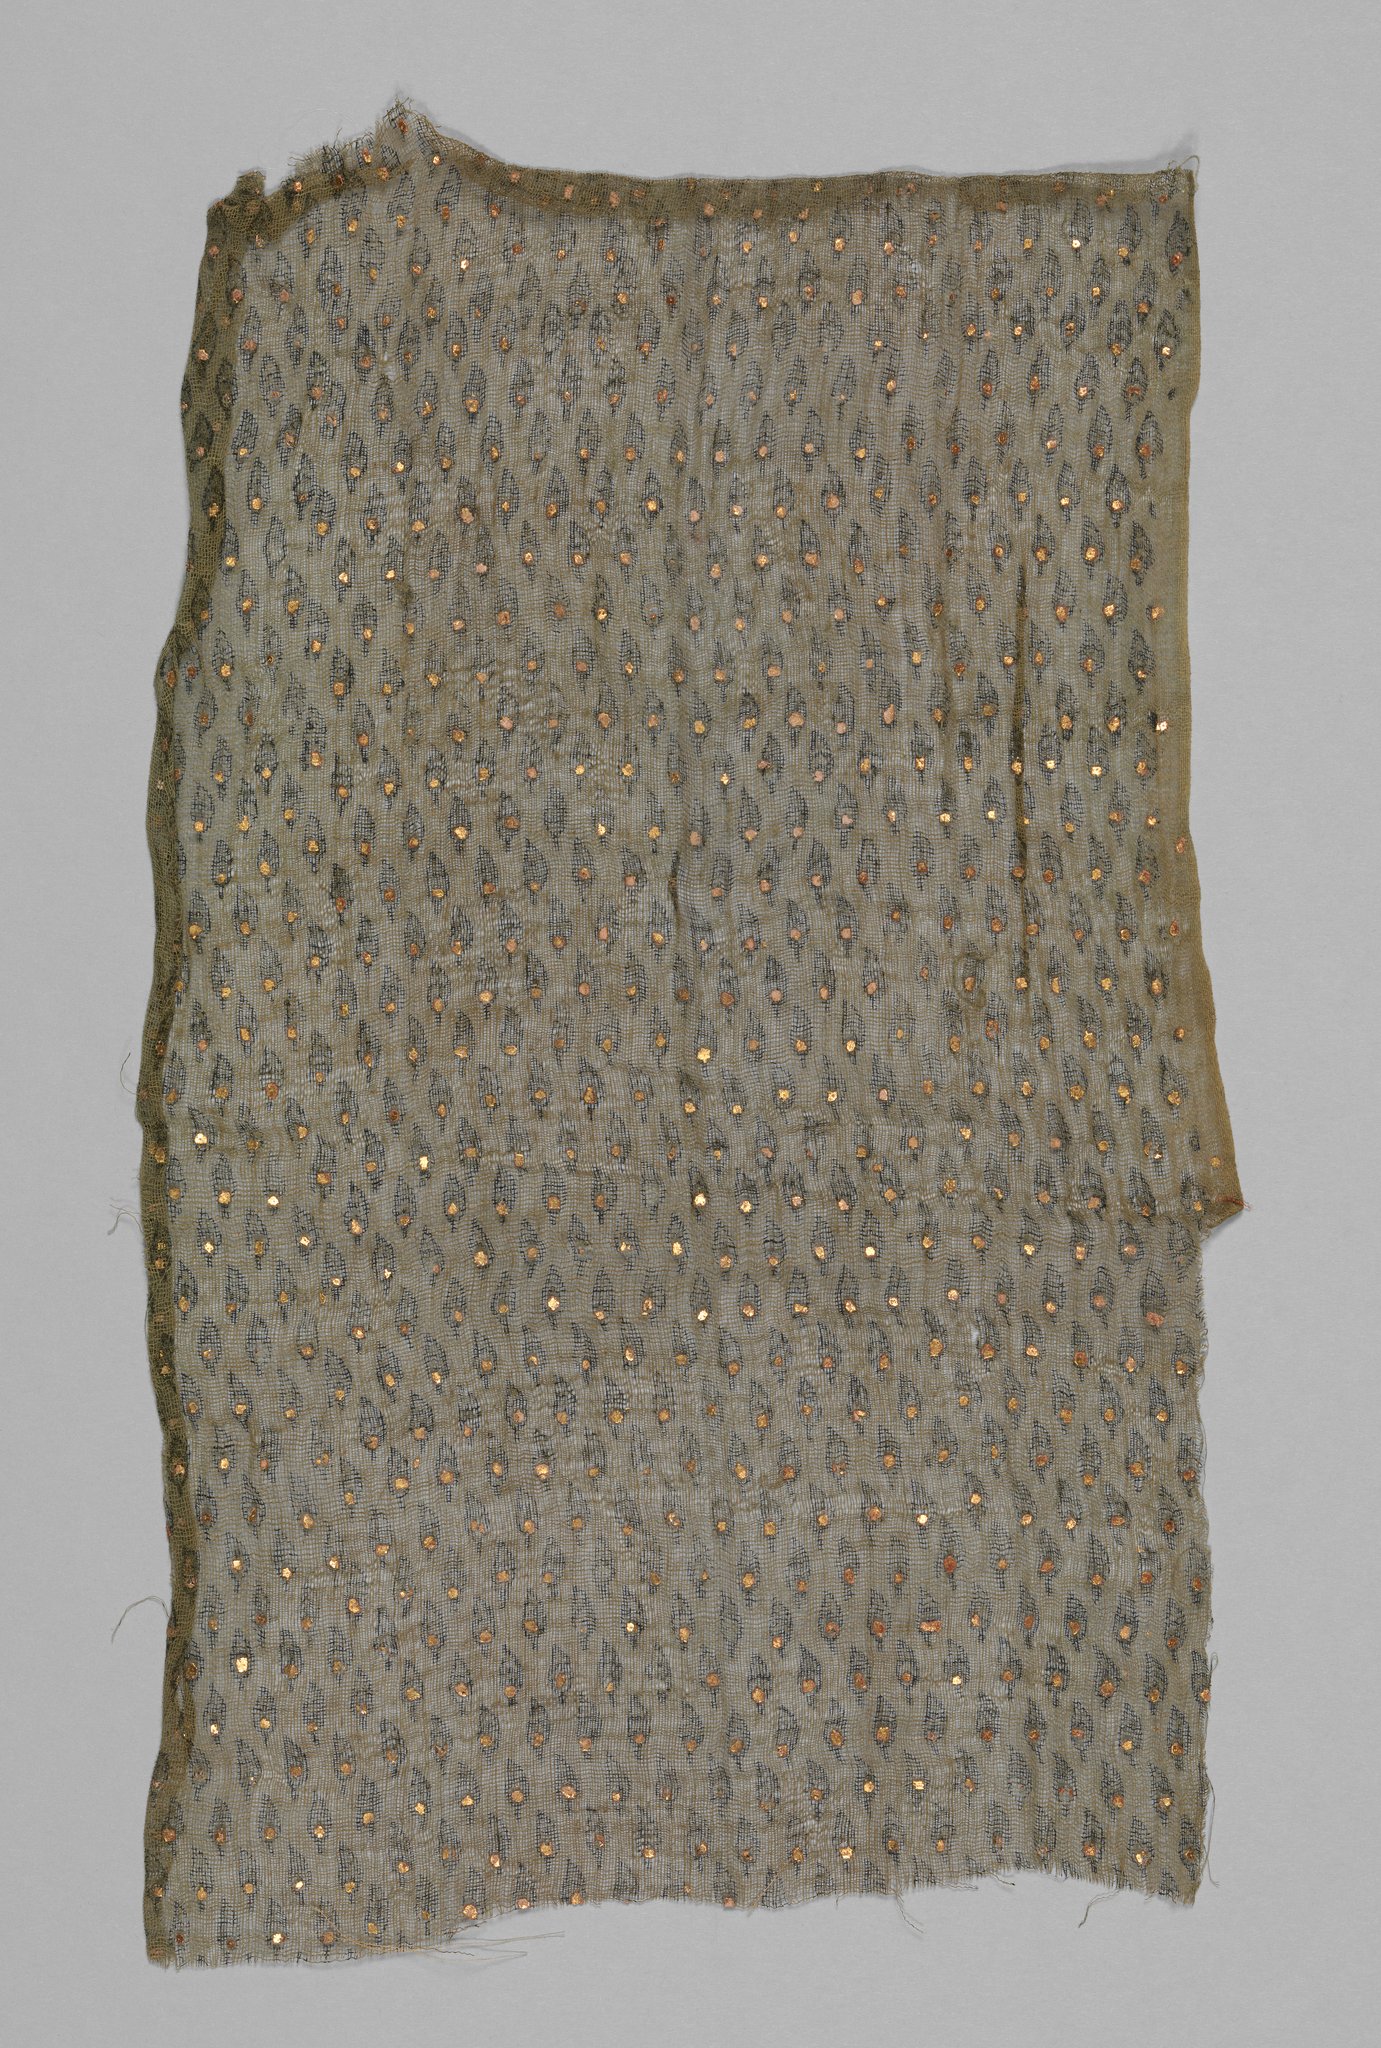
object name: textile fragment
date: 1701-1800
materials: cotton, metal thread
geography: india